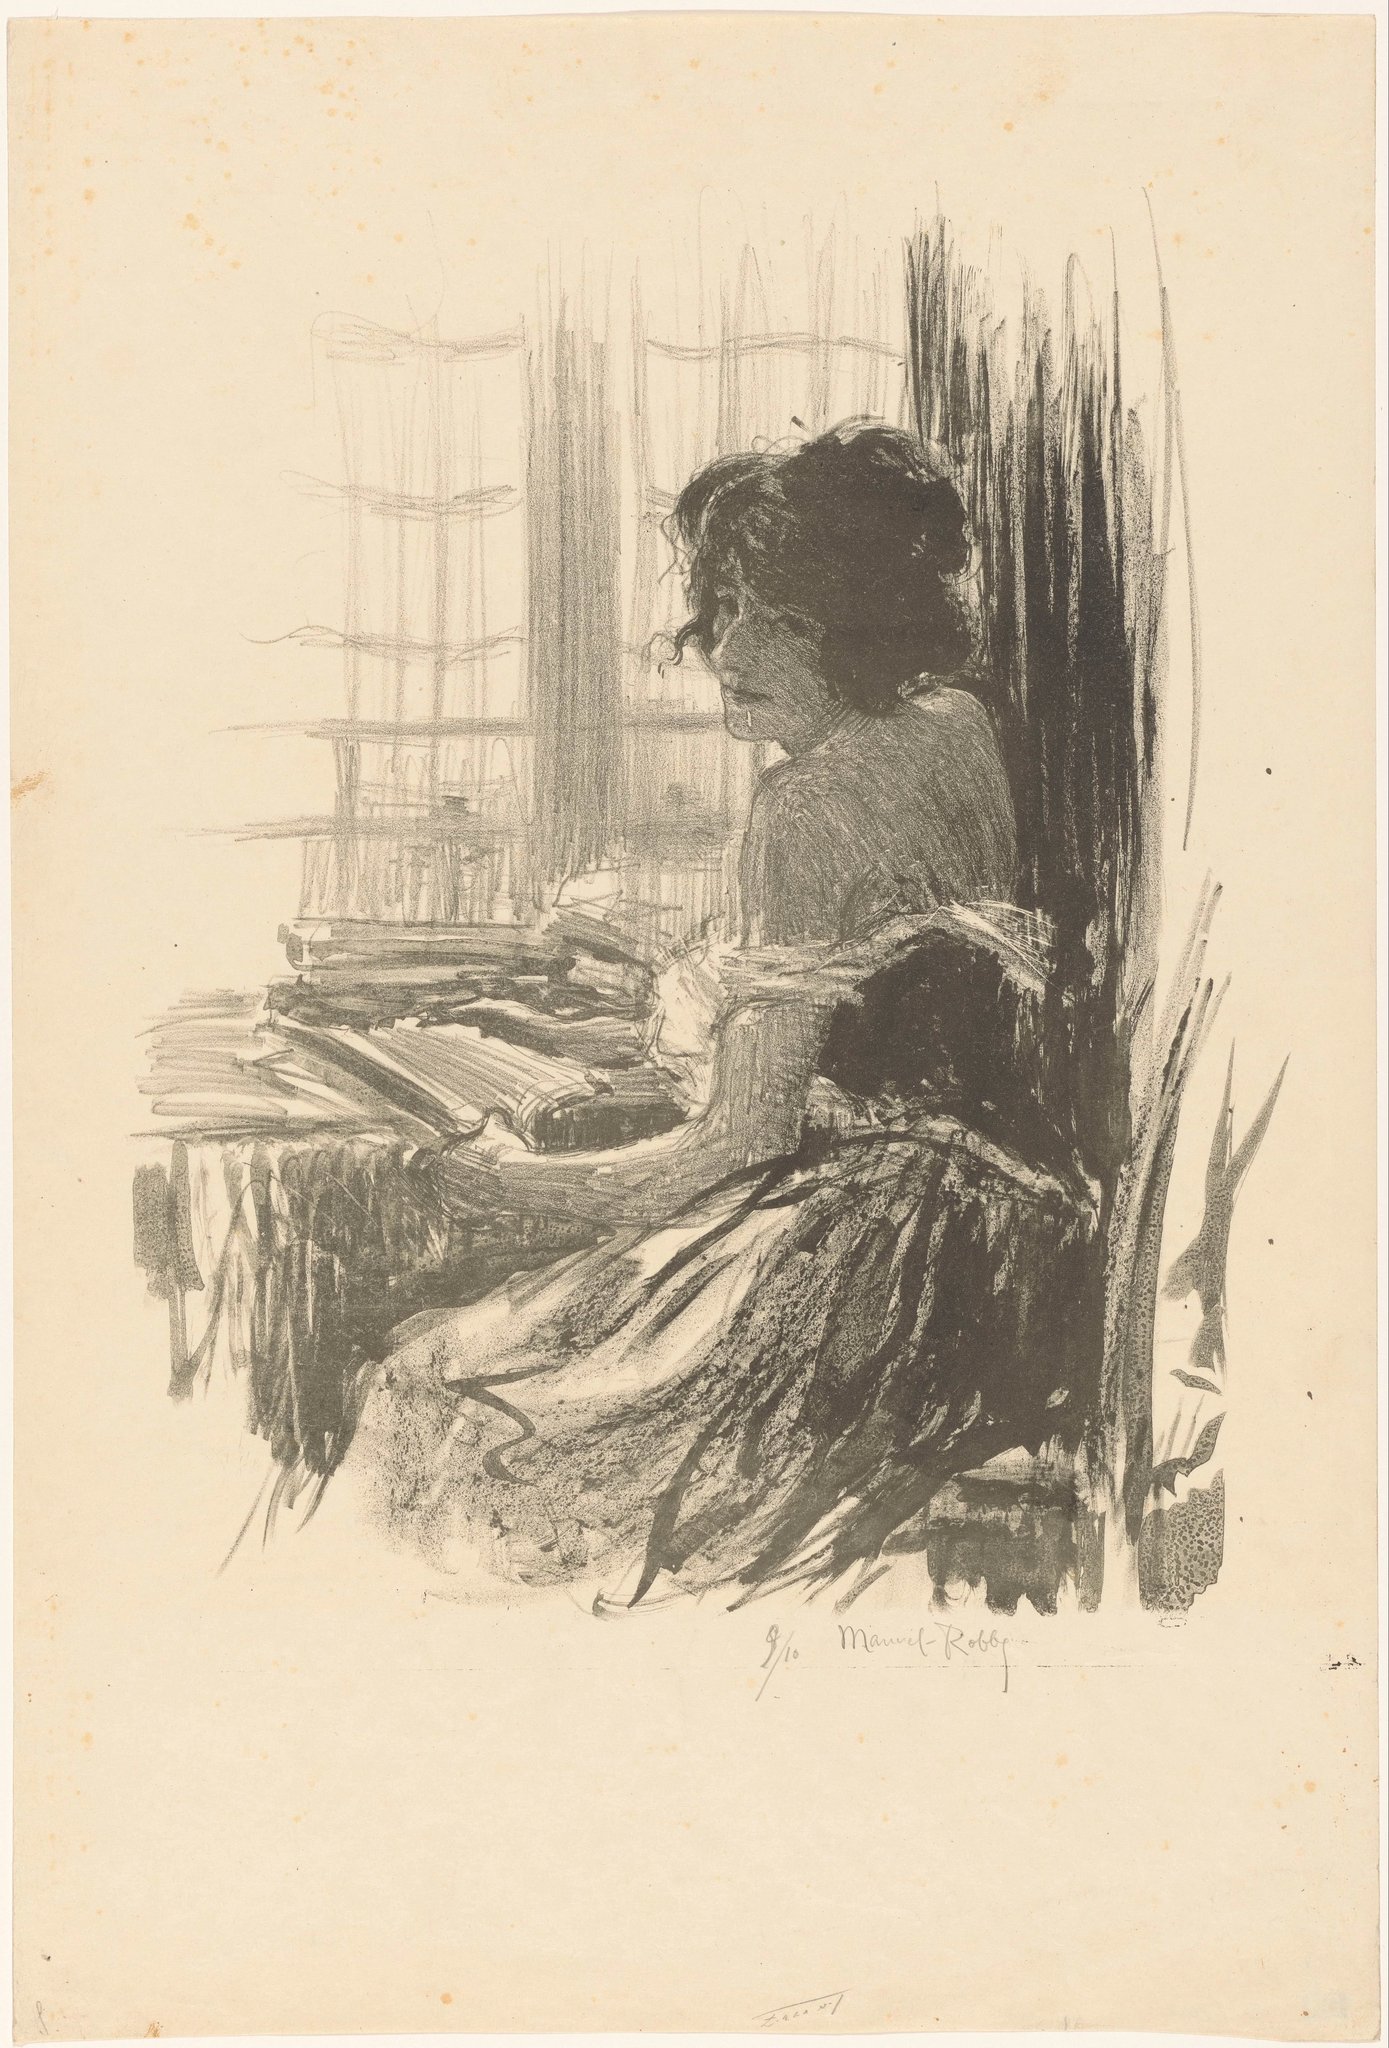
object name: print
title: Lezende vrouw achter een tafel voor het raam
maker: manuel robbe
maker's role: print maker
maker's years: 1872-1936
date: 1882-1936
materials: paper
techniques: lithograph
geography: paris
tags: reading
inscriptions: collector's mark: Lugt 2228, collector's mark: Lugt 4779